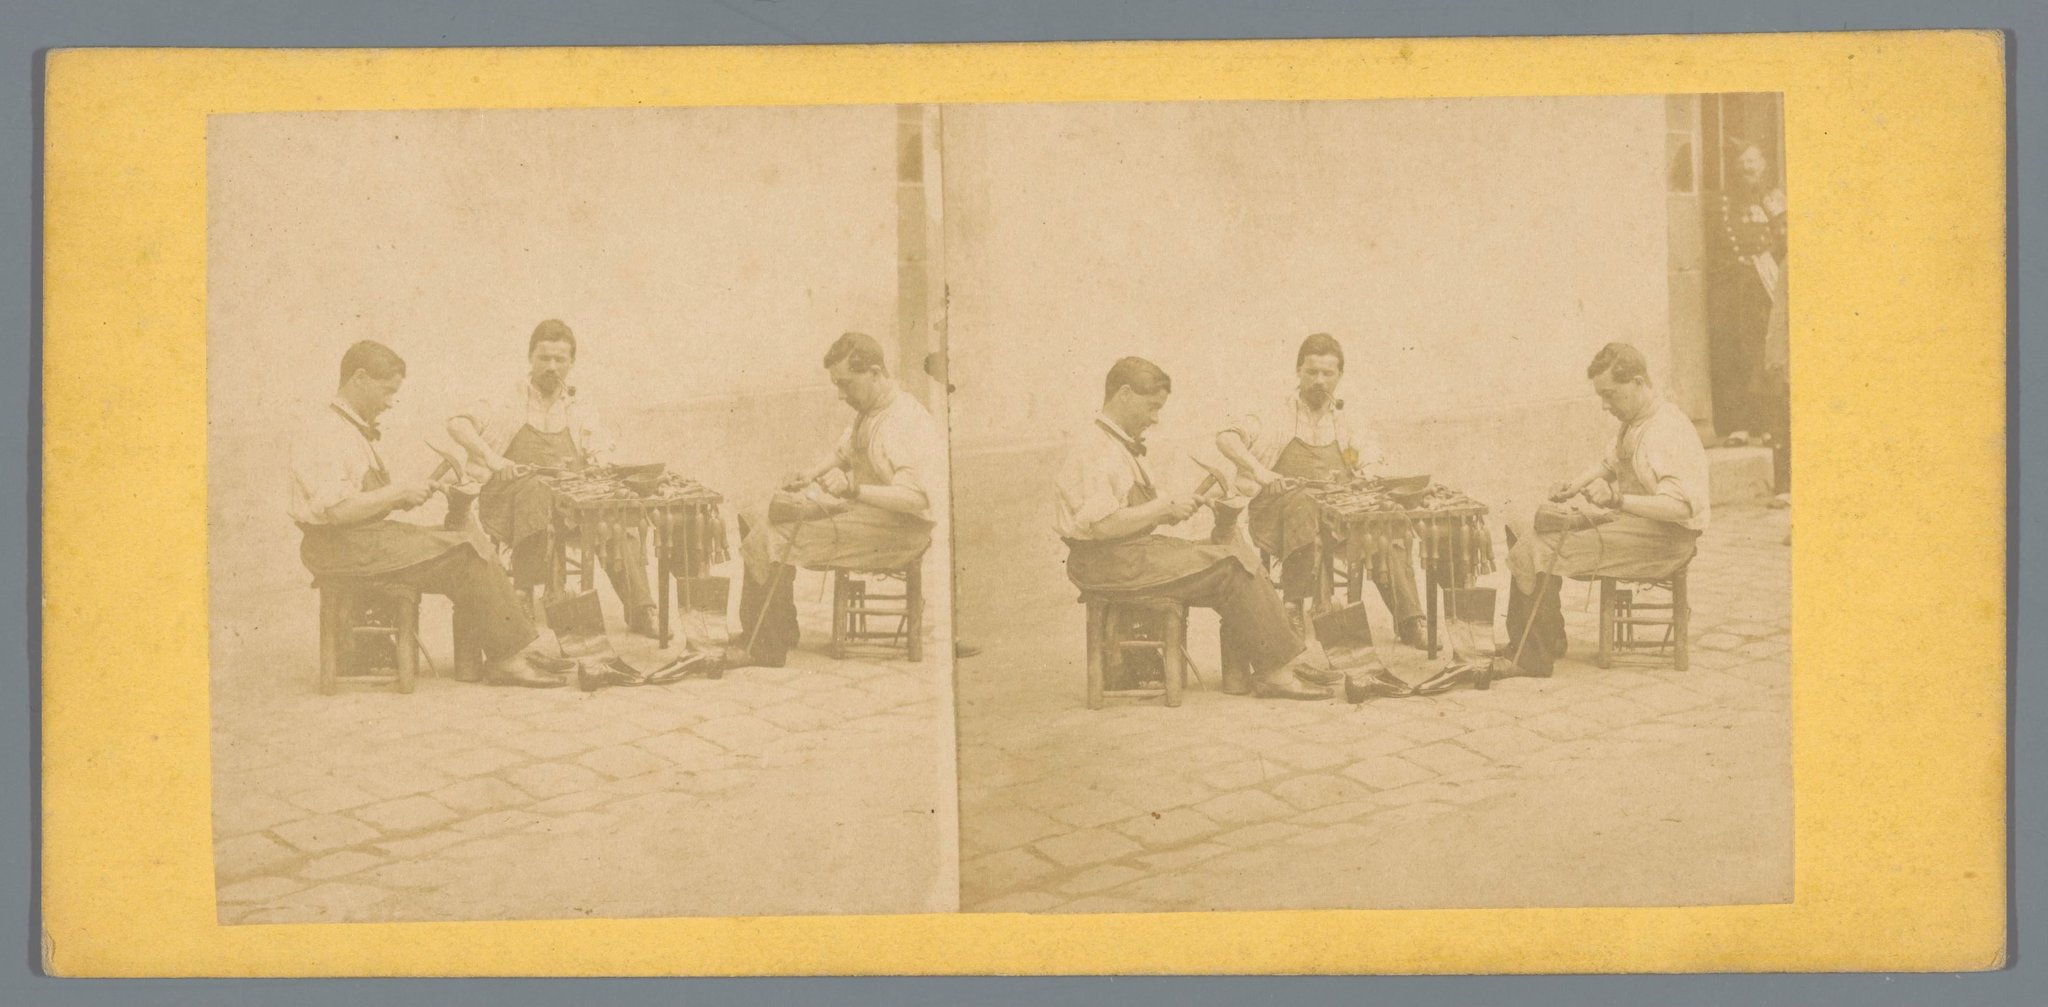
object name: stereograph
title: Drie schoenmakers aan het werk op straat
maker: Anonymous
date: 1850-1880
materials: cardboard, photographic support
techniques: albumen print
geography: europe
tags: shoe-maker, cobbler, europe